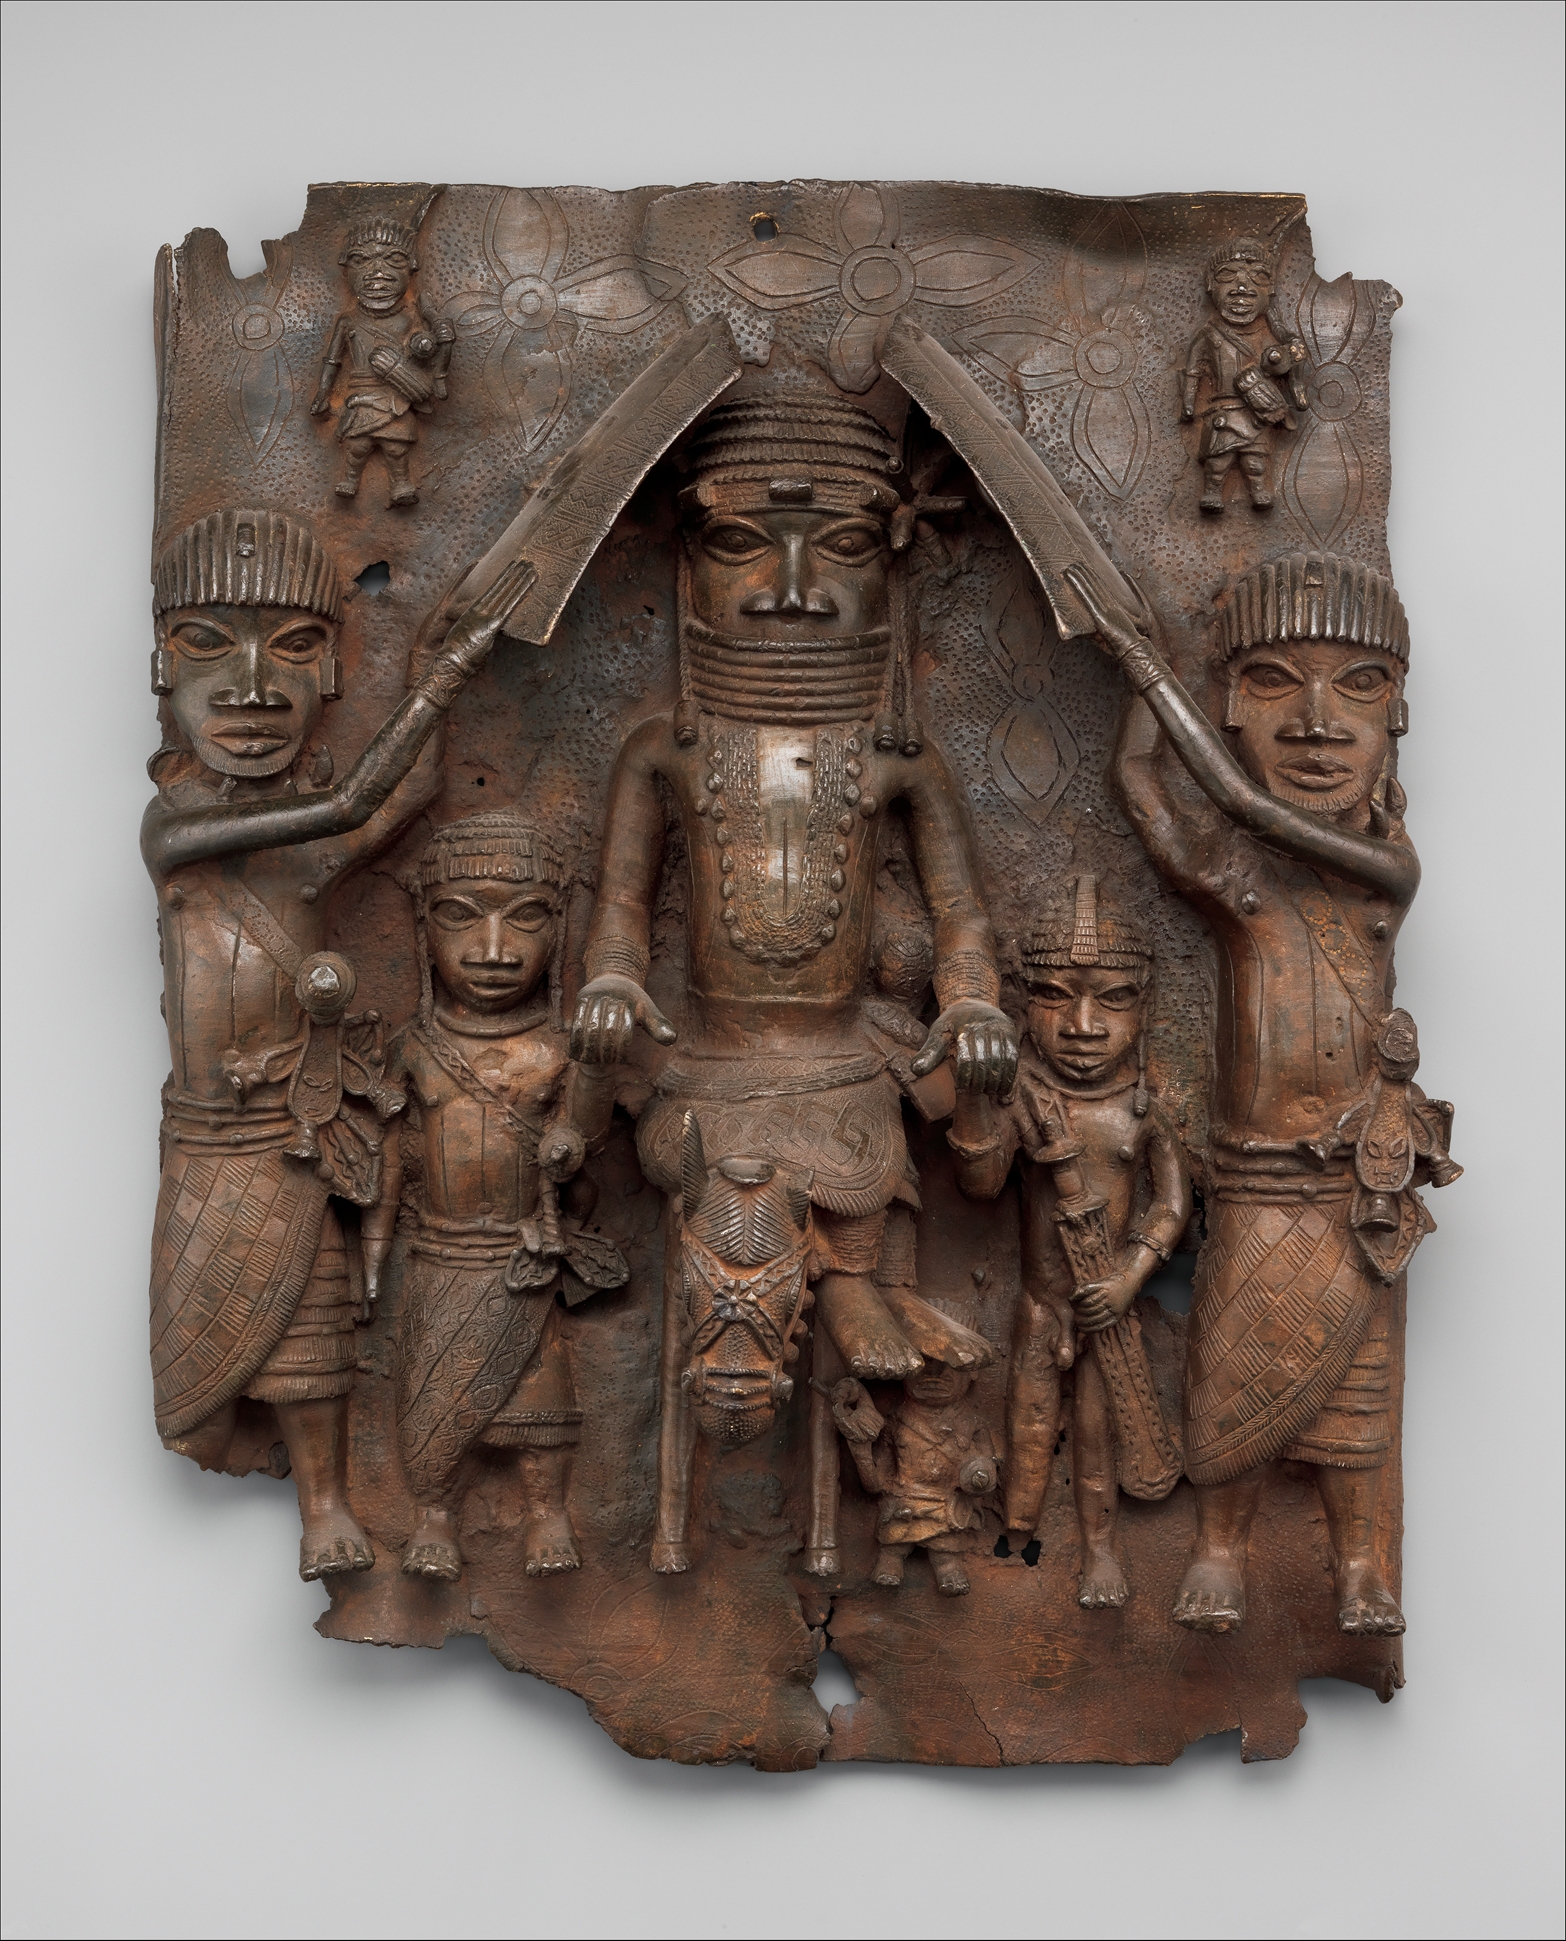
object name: plaque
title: Plaque with equestrian ọ́bà (king) and attendants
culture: edo period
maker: ìgùn ẹ́rọ̀nwwọ̀n (brass-casting guild) artists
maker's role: artist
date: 1540-1570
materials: brass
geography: nigeria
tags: kings,men,horses